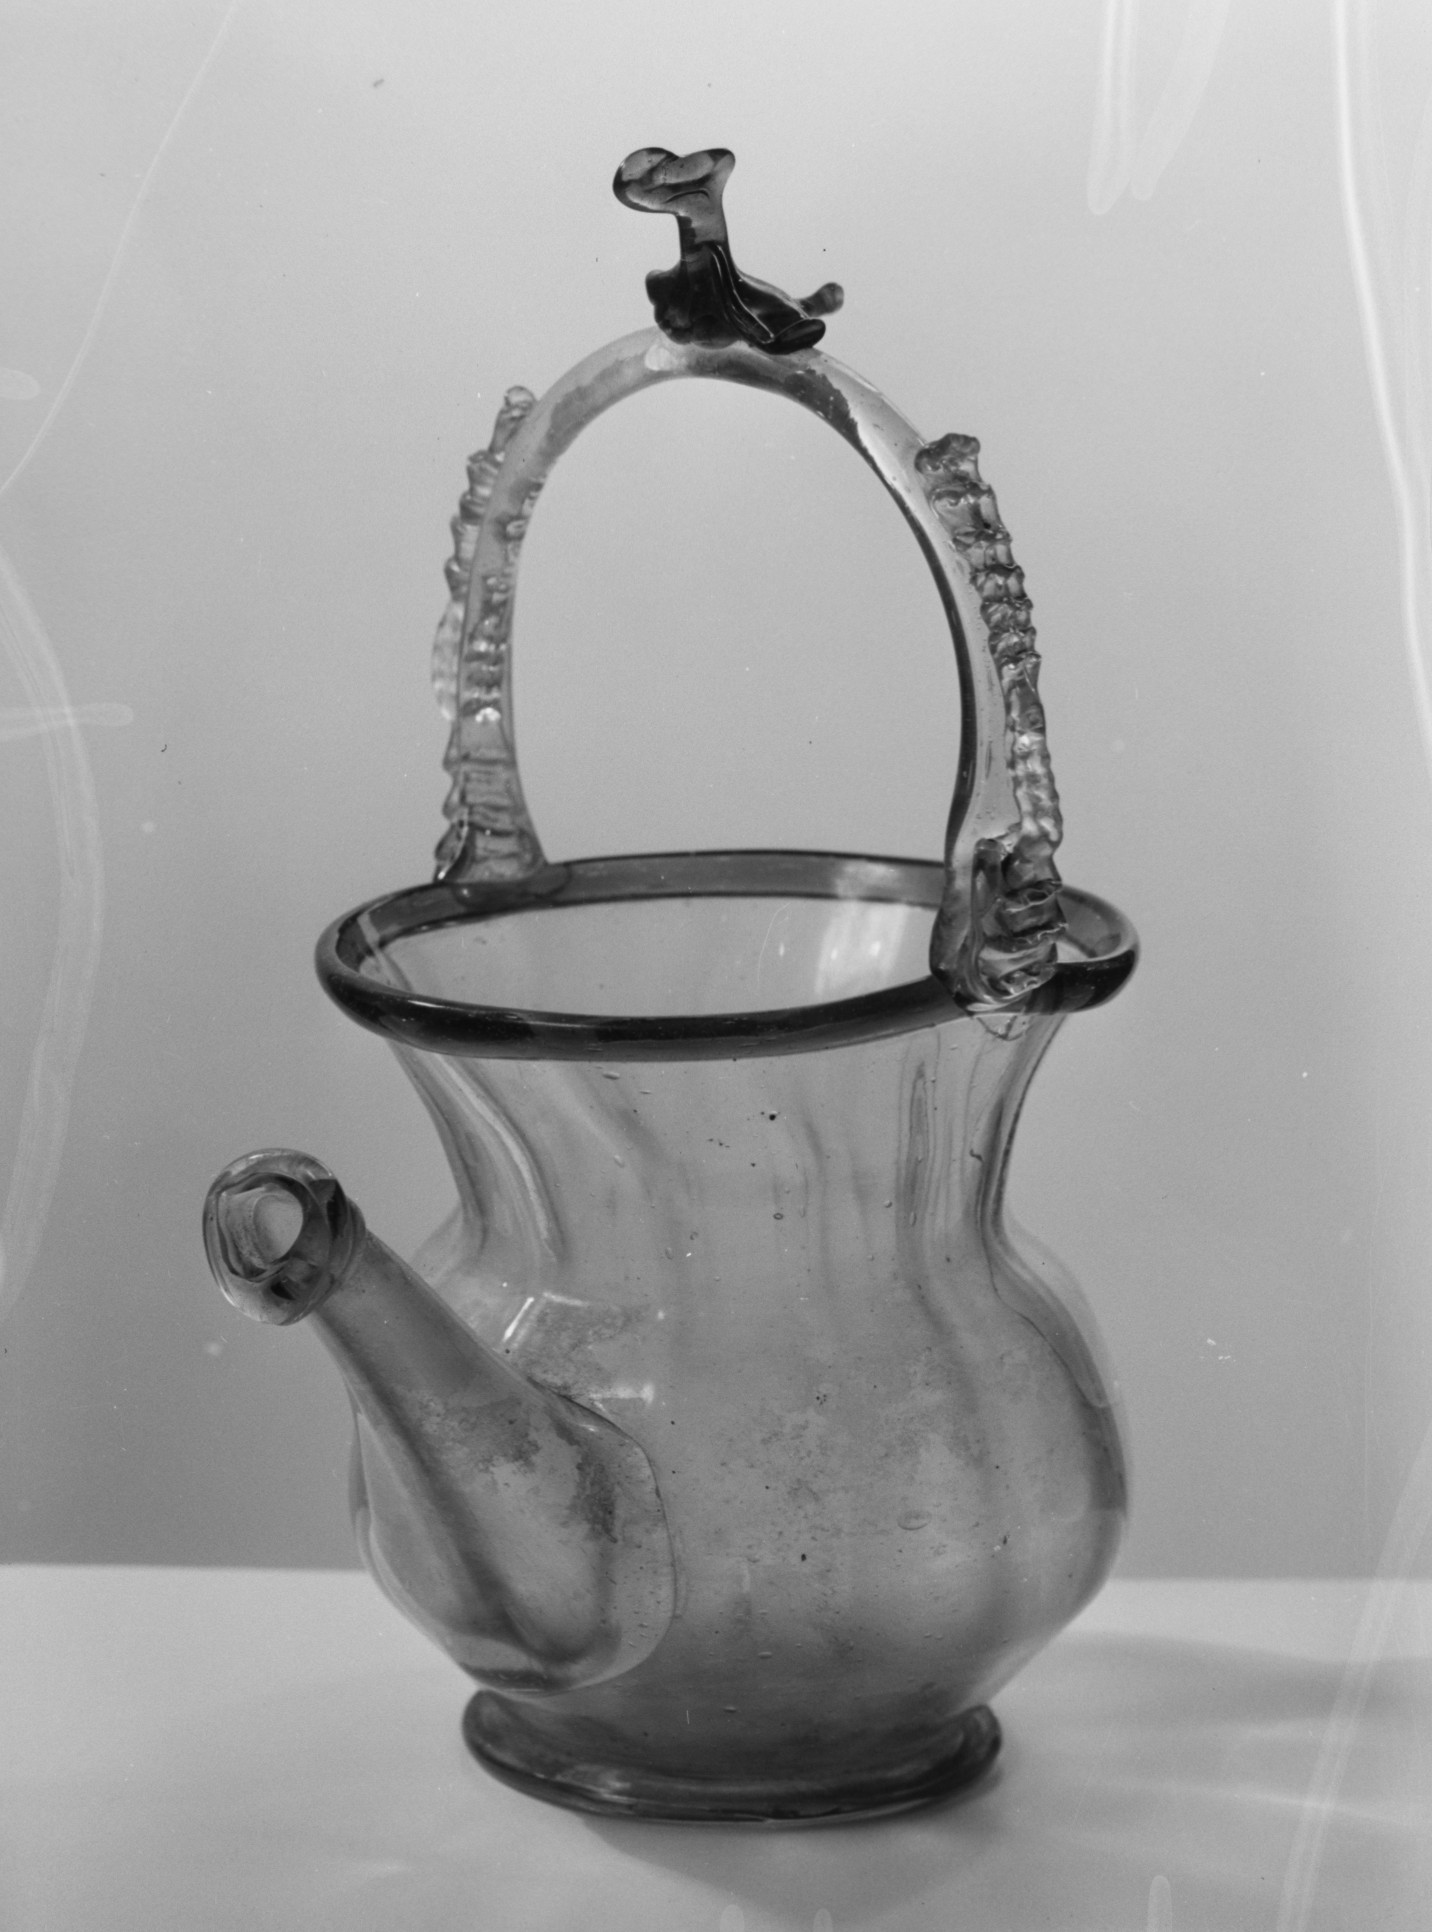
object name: jug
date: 1601-1800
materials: glass